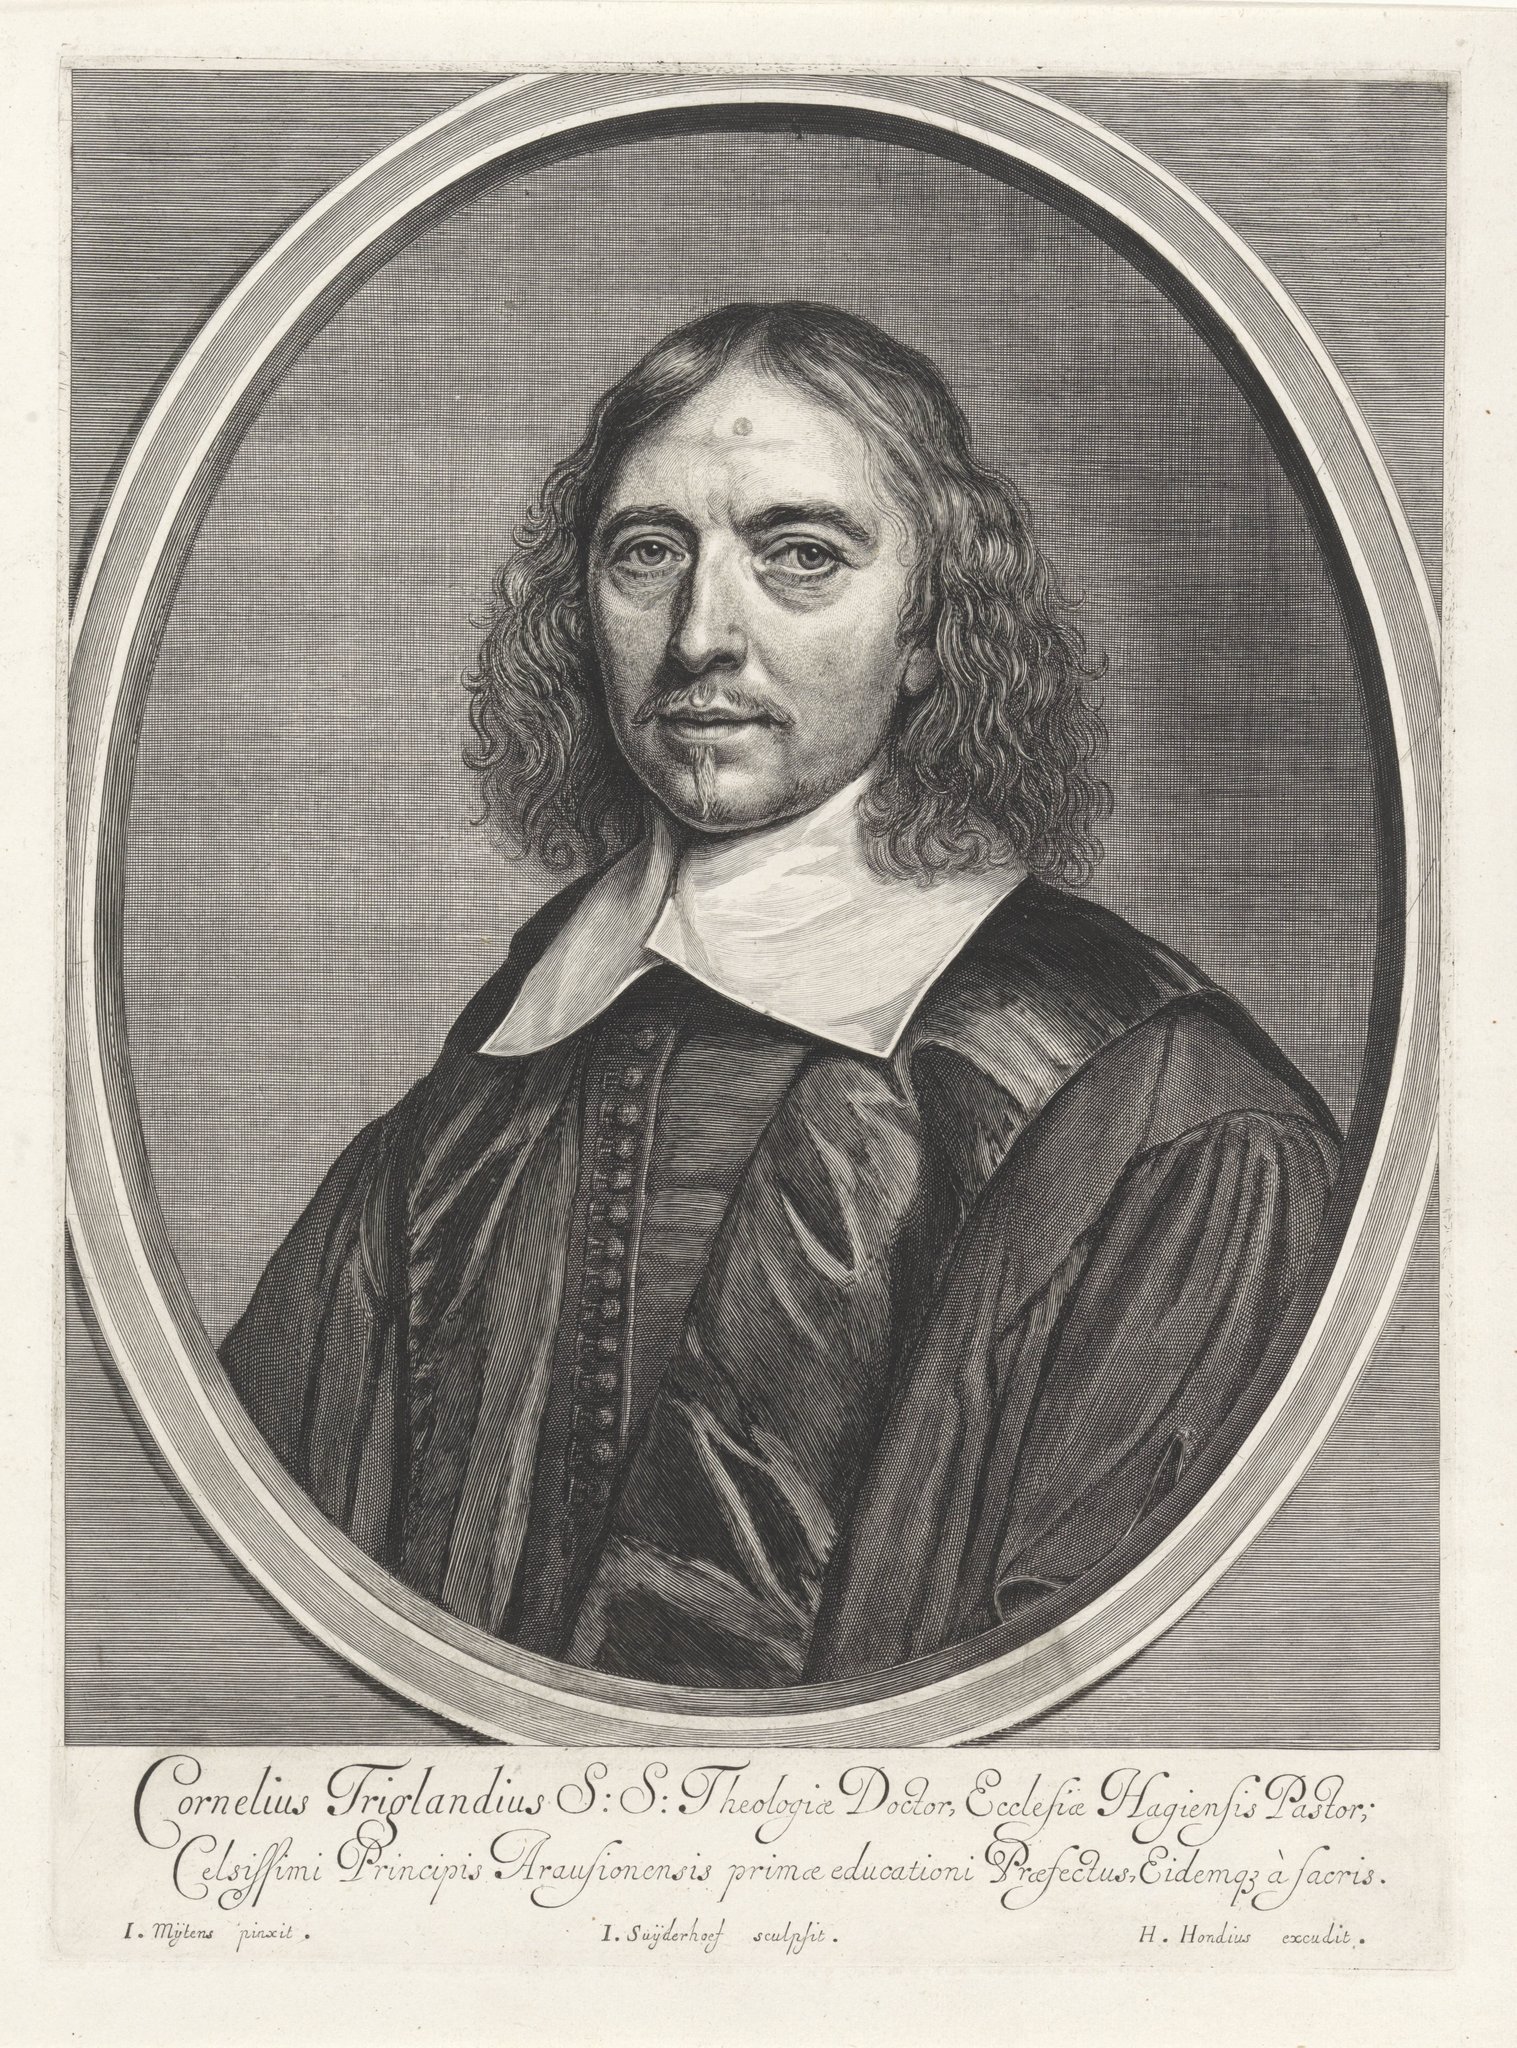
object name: print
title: Portret van Cornelis Trigland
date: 1656-1686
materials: paper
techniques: engraving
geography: haarlem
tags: amsterdam, the hague, functionaries and dignitaries ~ protestant churches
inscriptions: collector's mark: Lugt 240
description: Portret van Cornelis Trigland, doctor in de theologie, predikant te Den Haag en onderwijzer van prins Willem III. Onderaan in de marge zijn naam en functies in het Latijn.